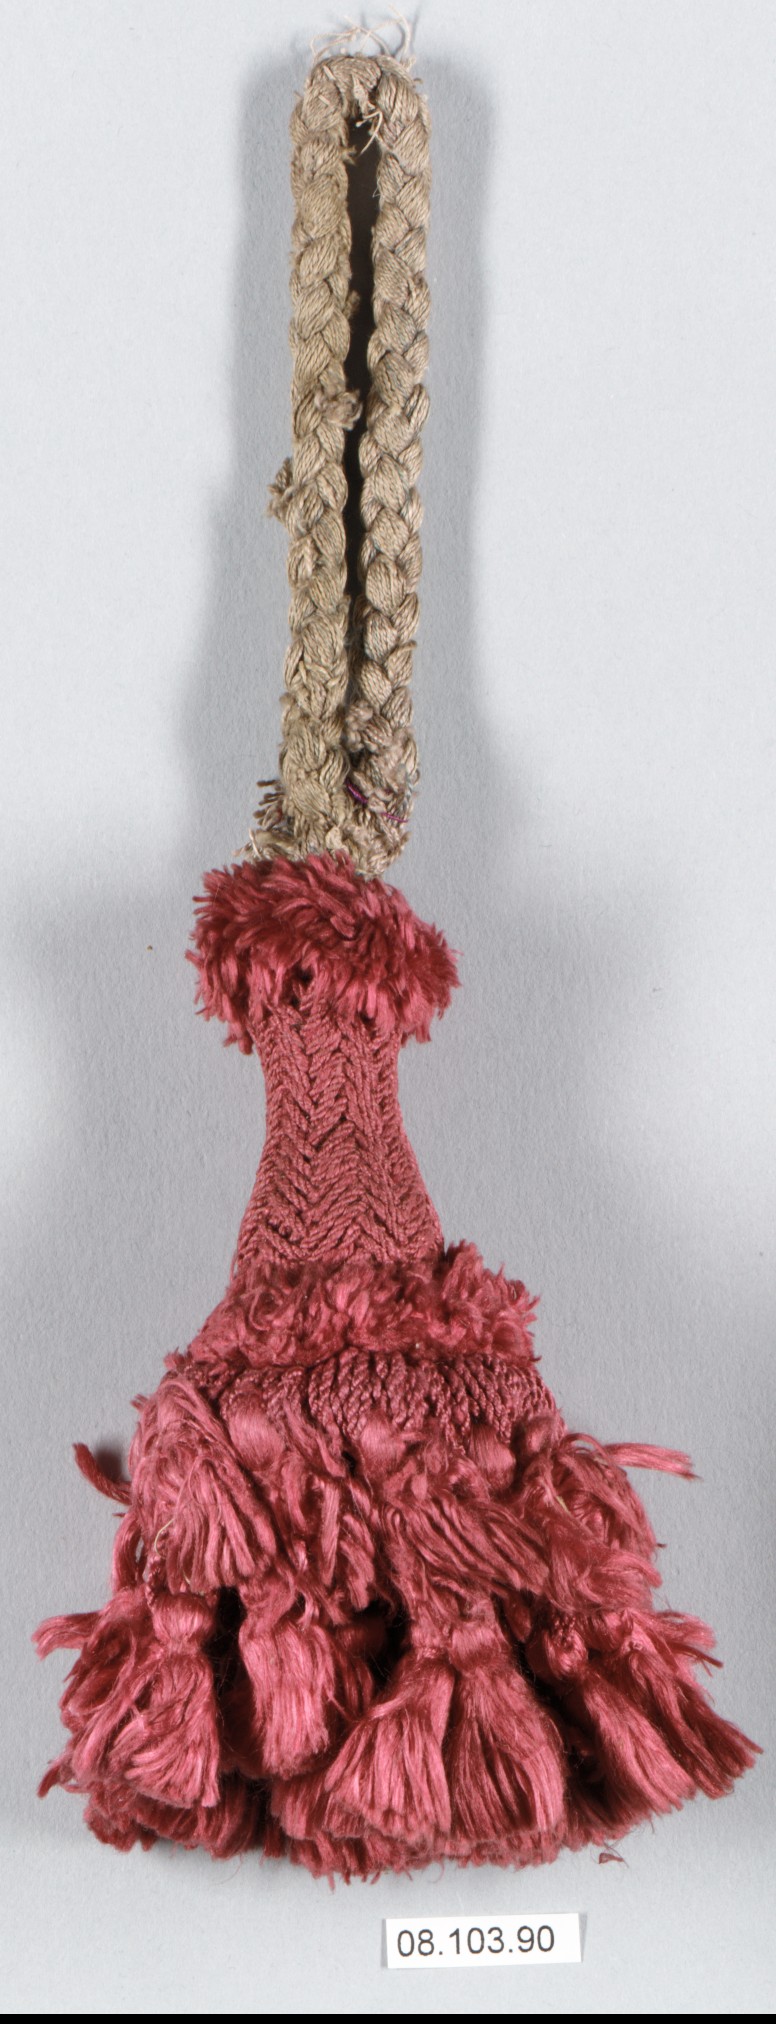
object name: tassel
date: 1567-1633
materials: silk